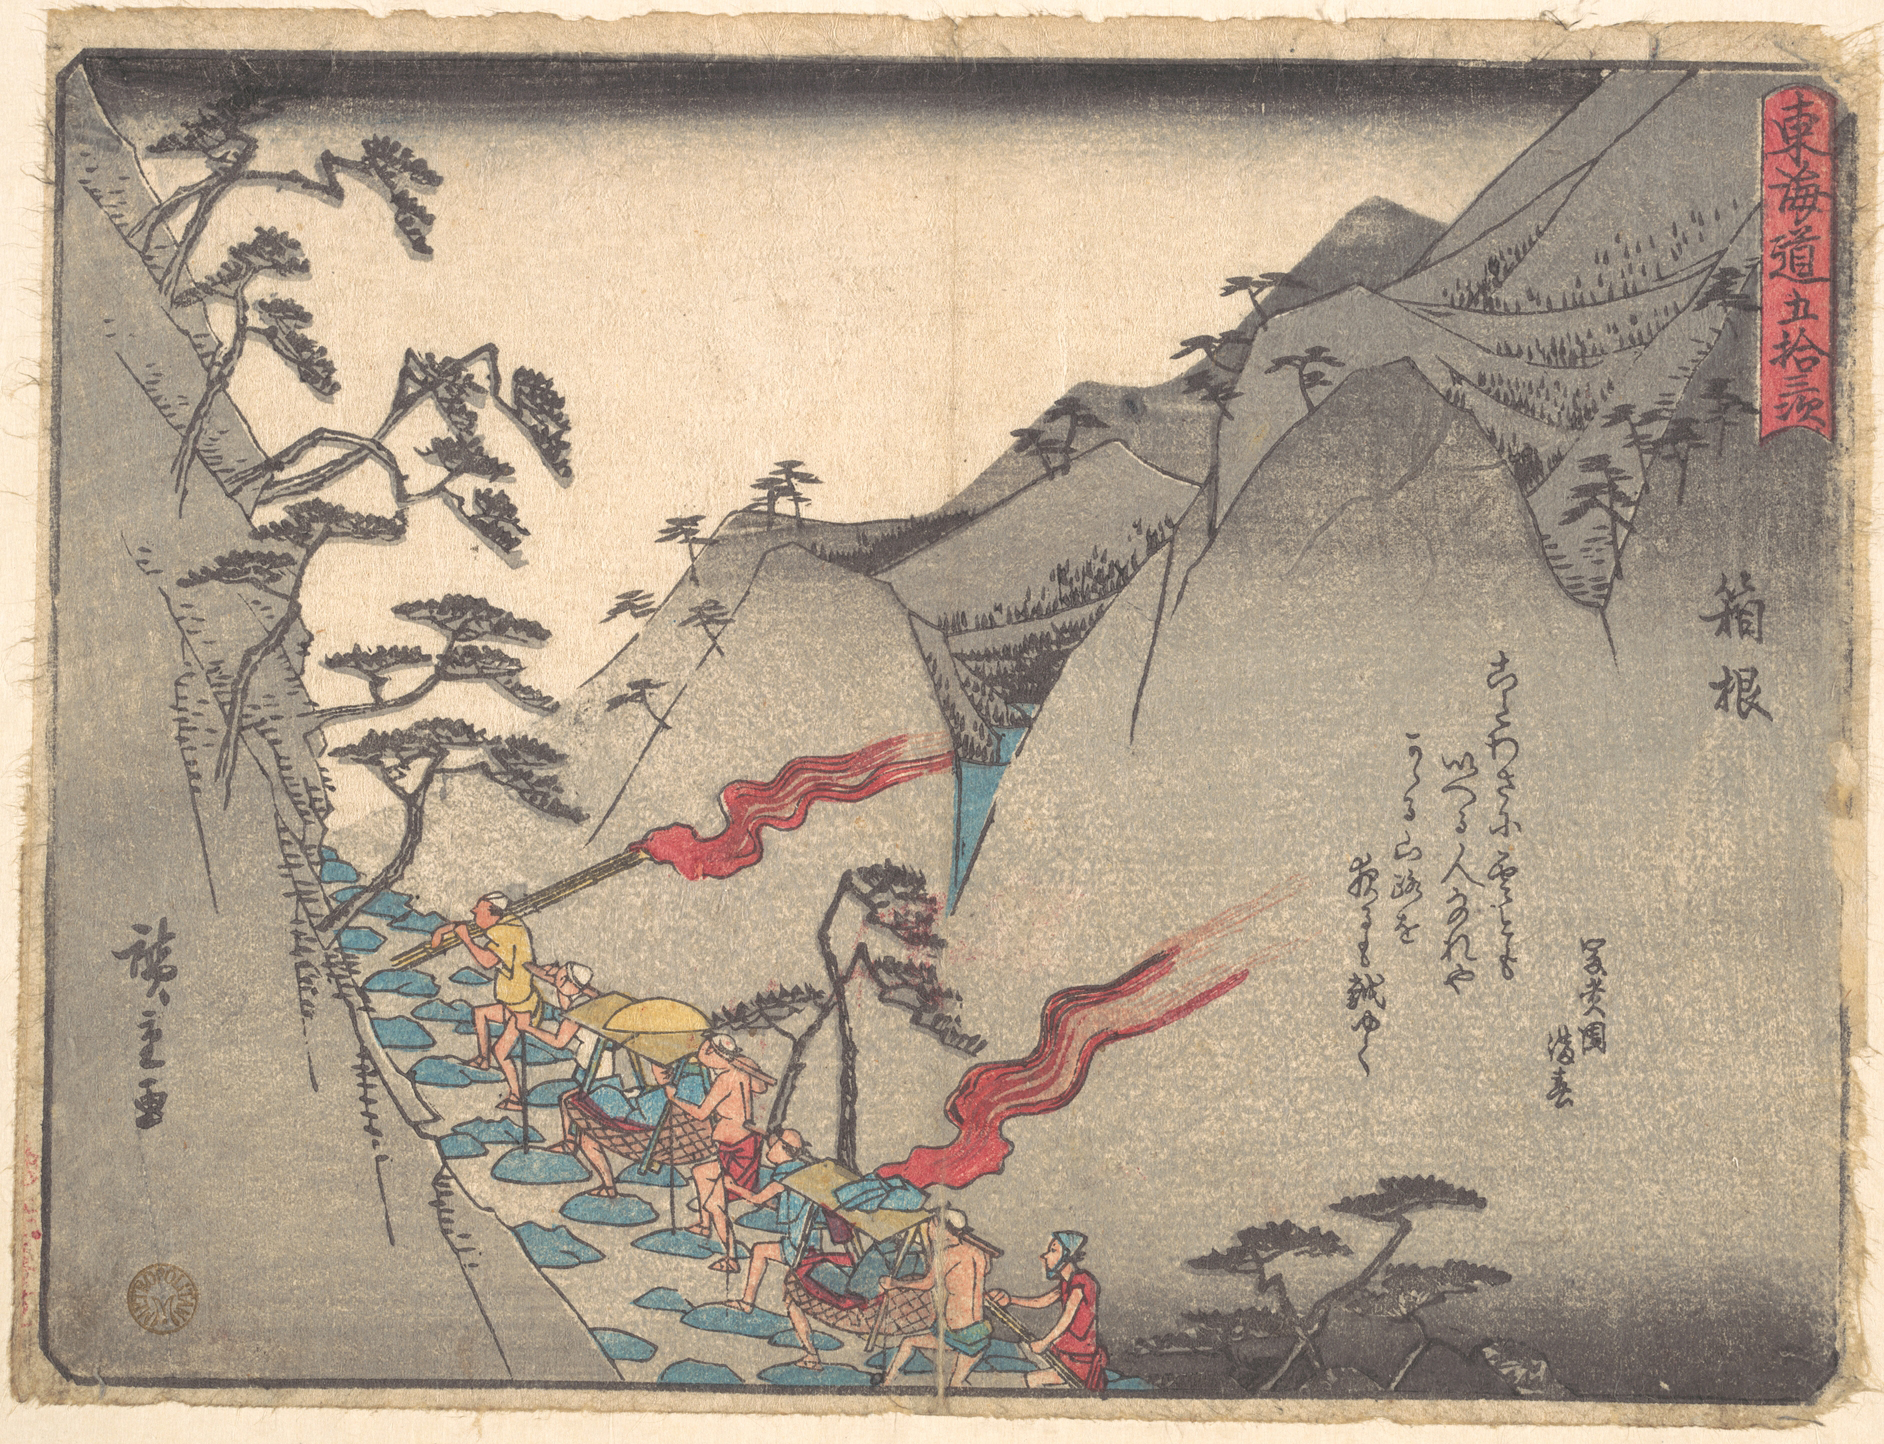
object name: print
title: Hakone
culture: japanese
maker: utagawa hiroshige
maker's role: artist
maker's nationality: japanese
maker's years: 1797-1858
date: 1838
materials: ink, paper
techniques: woodblock print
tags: men,mountains,trees